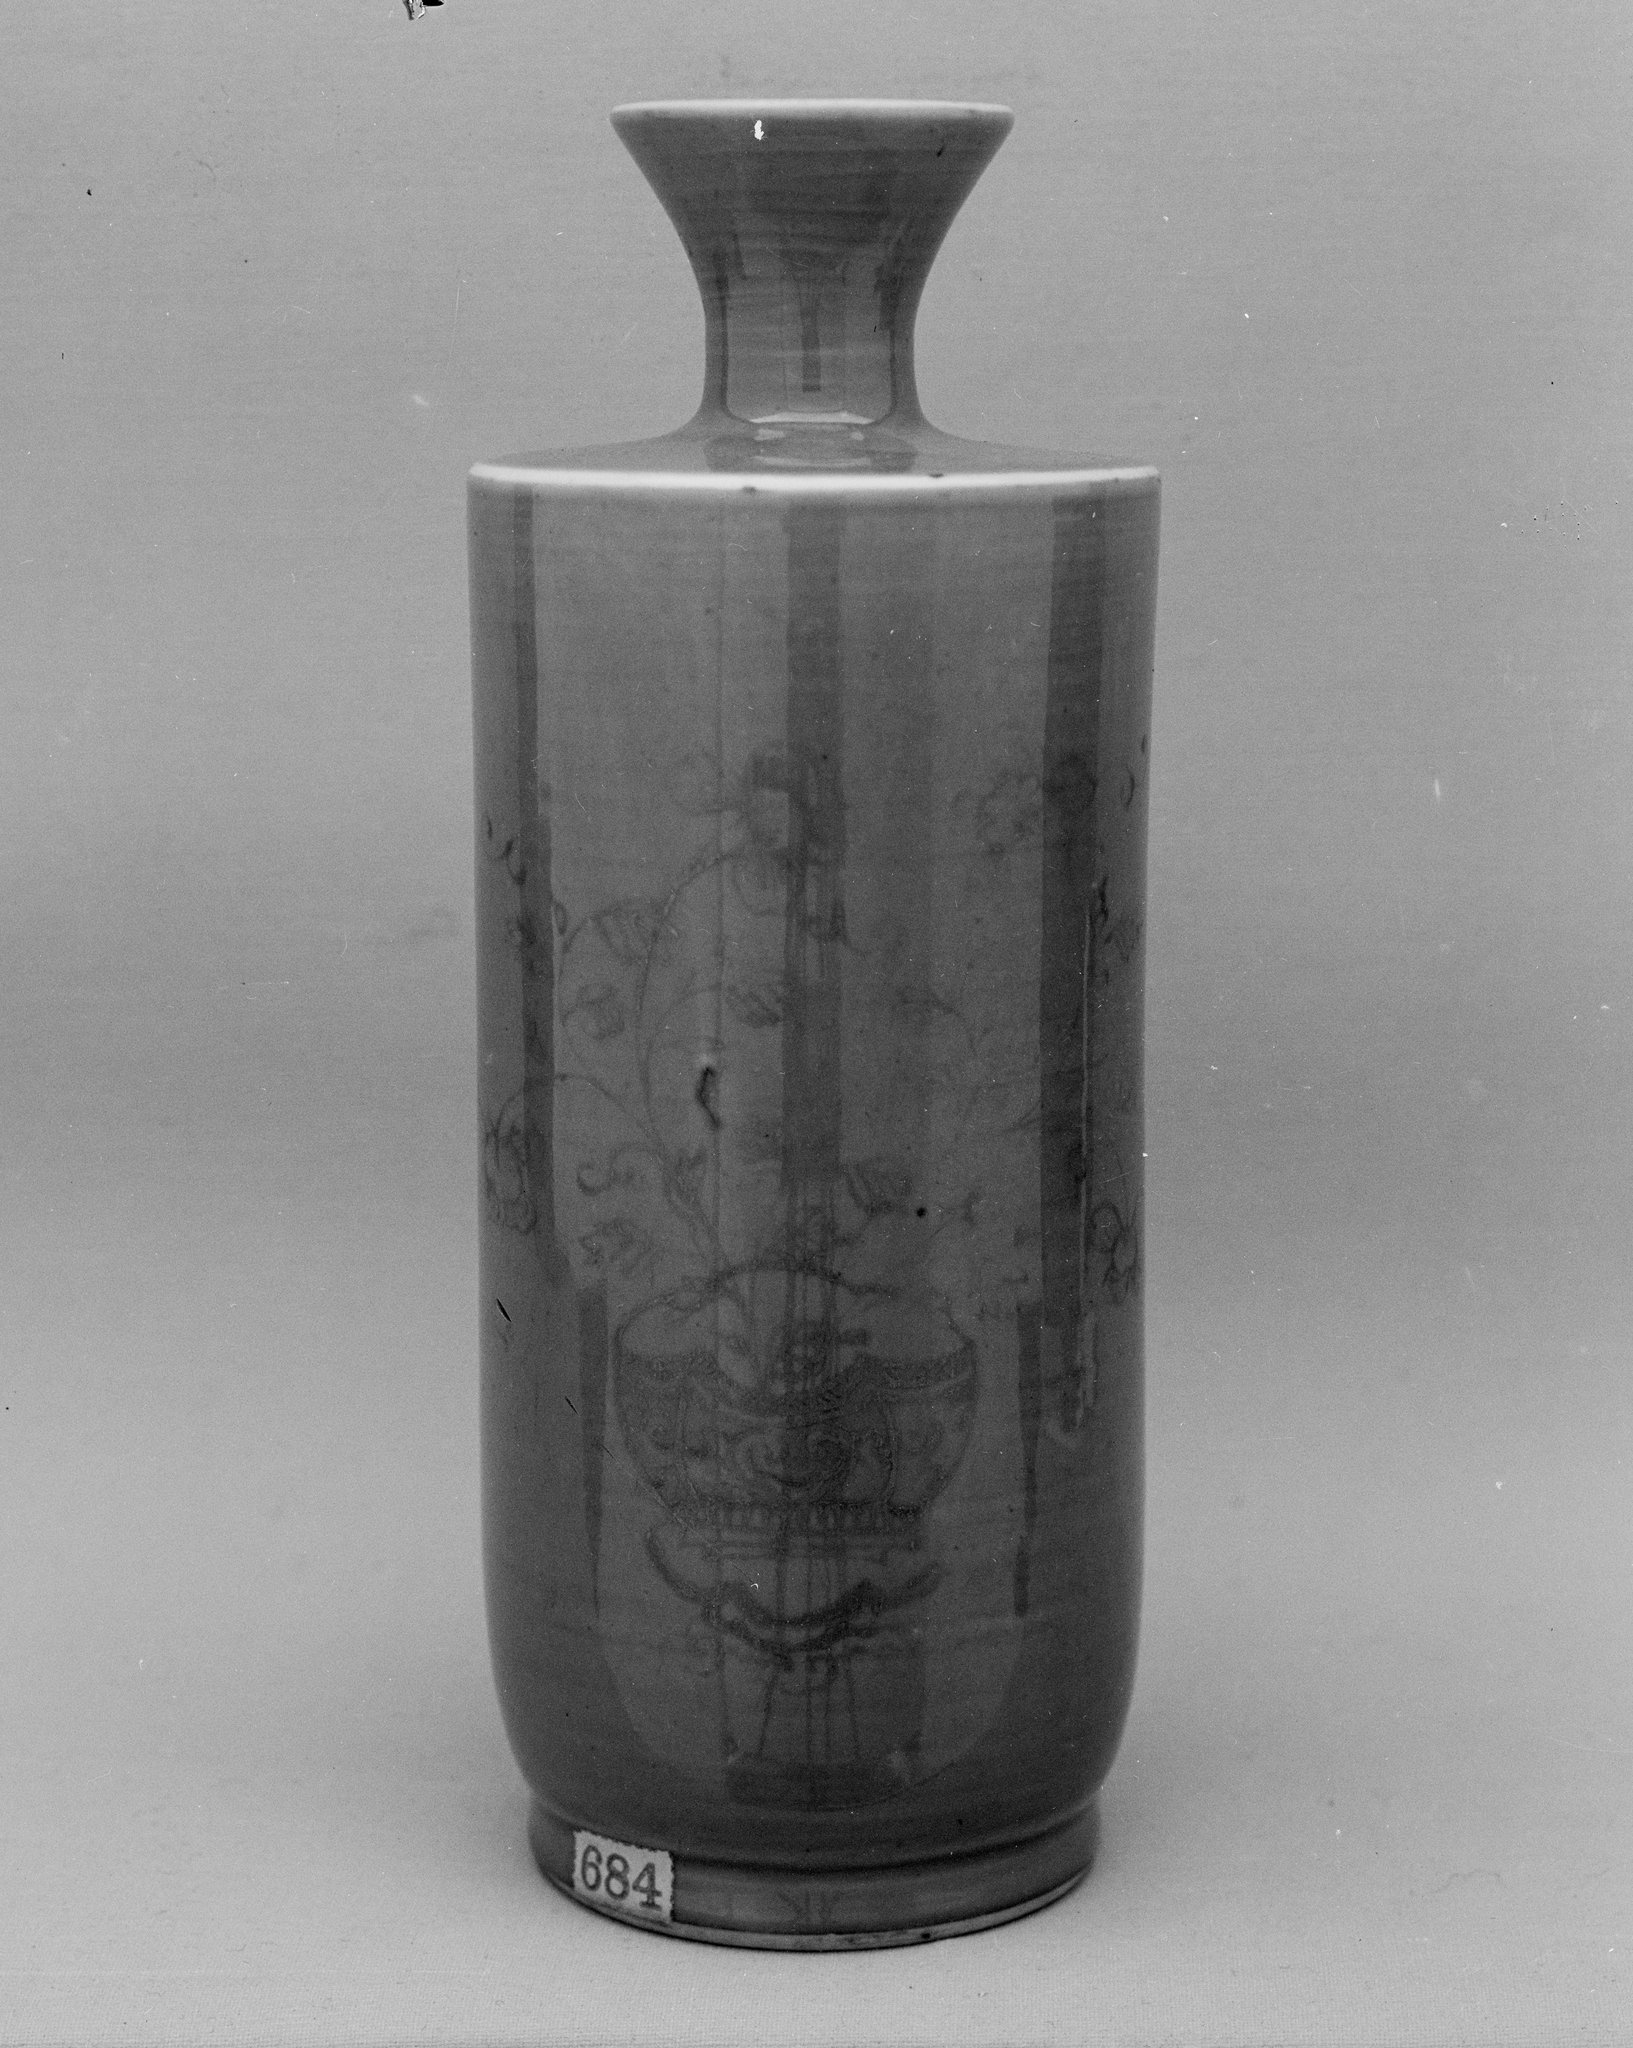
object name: vase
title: Vase with flowers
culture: chinese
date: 1701-1800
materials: glaze, gold, porcelain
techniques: painting